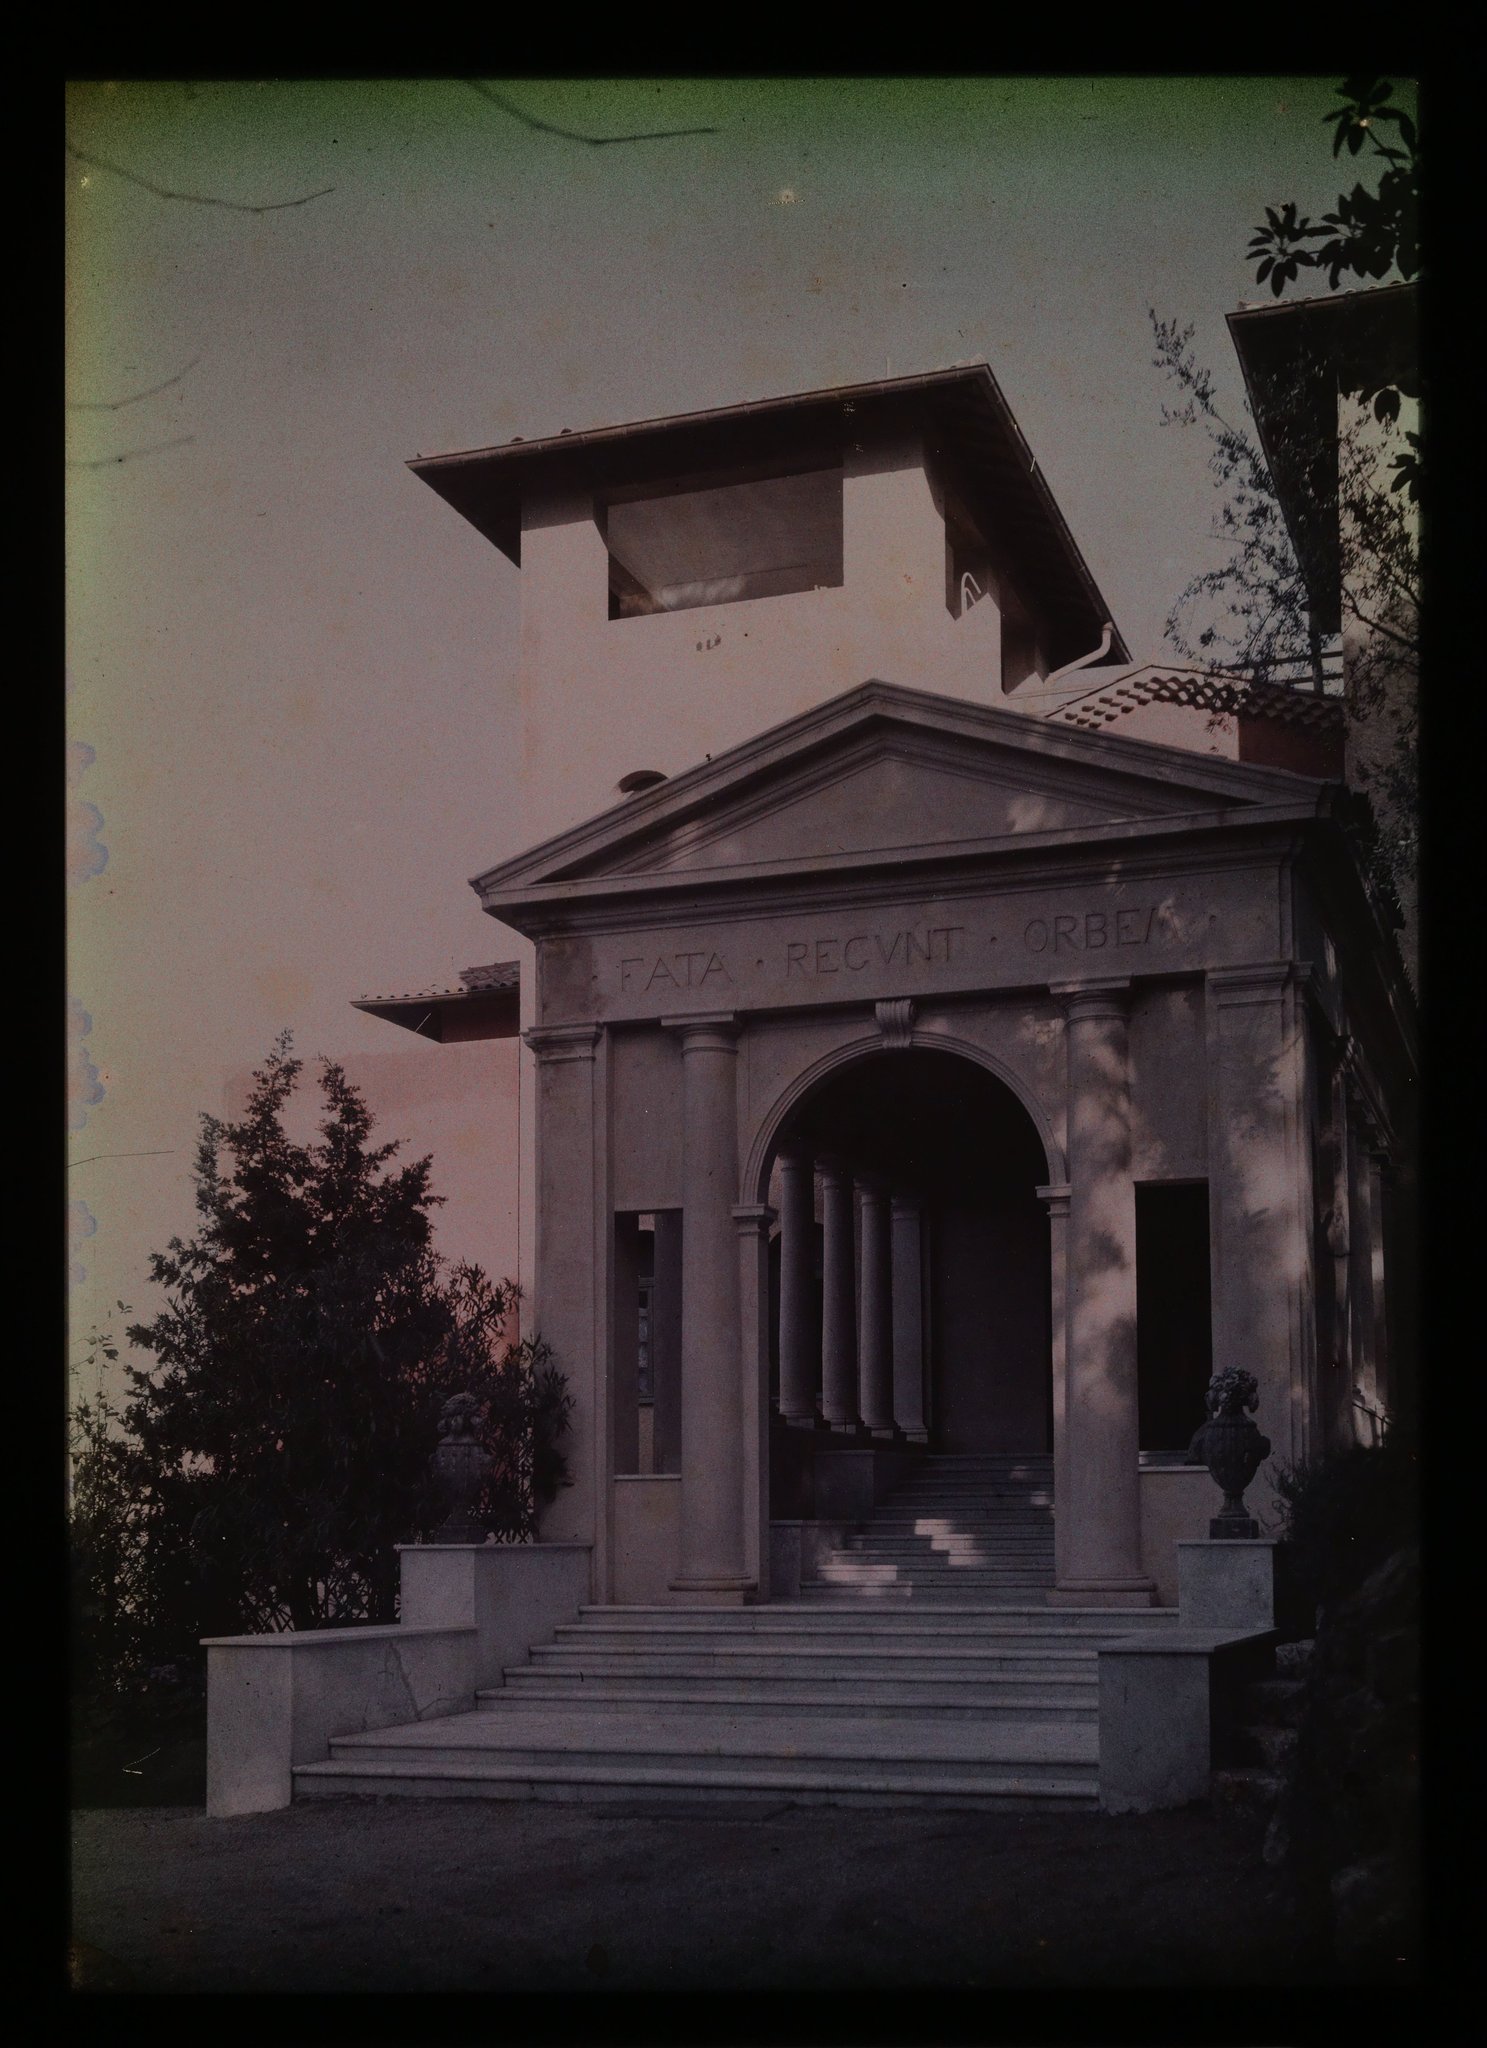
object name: photograph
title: Portico van een roze gepleisterd huis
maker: Anonymous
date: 1917-1940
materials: glass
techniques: autochrome process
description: Op de portico is te lezen: Fata Regunt Orbem.